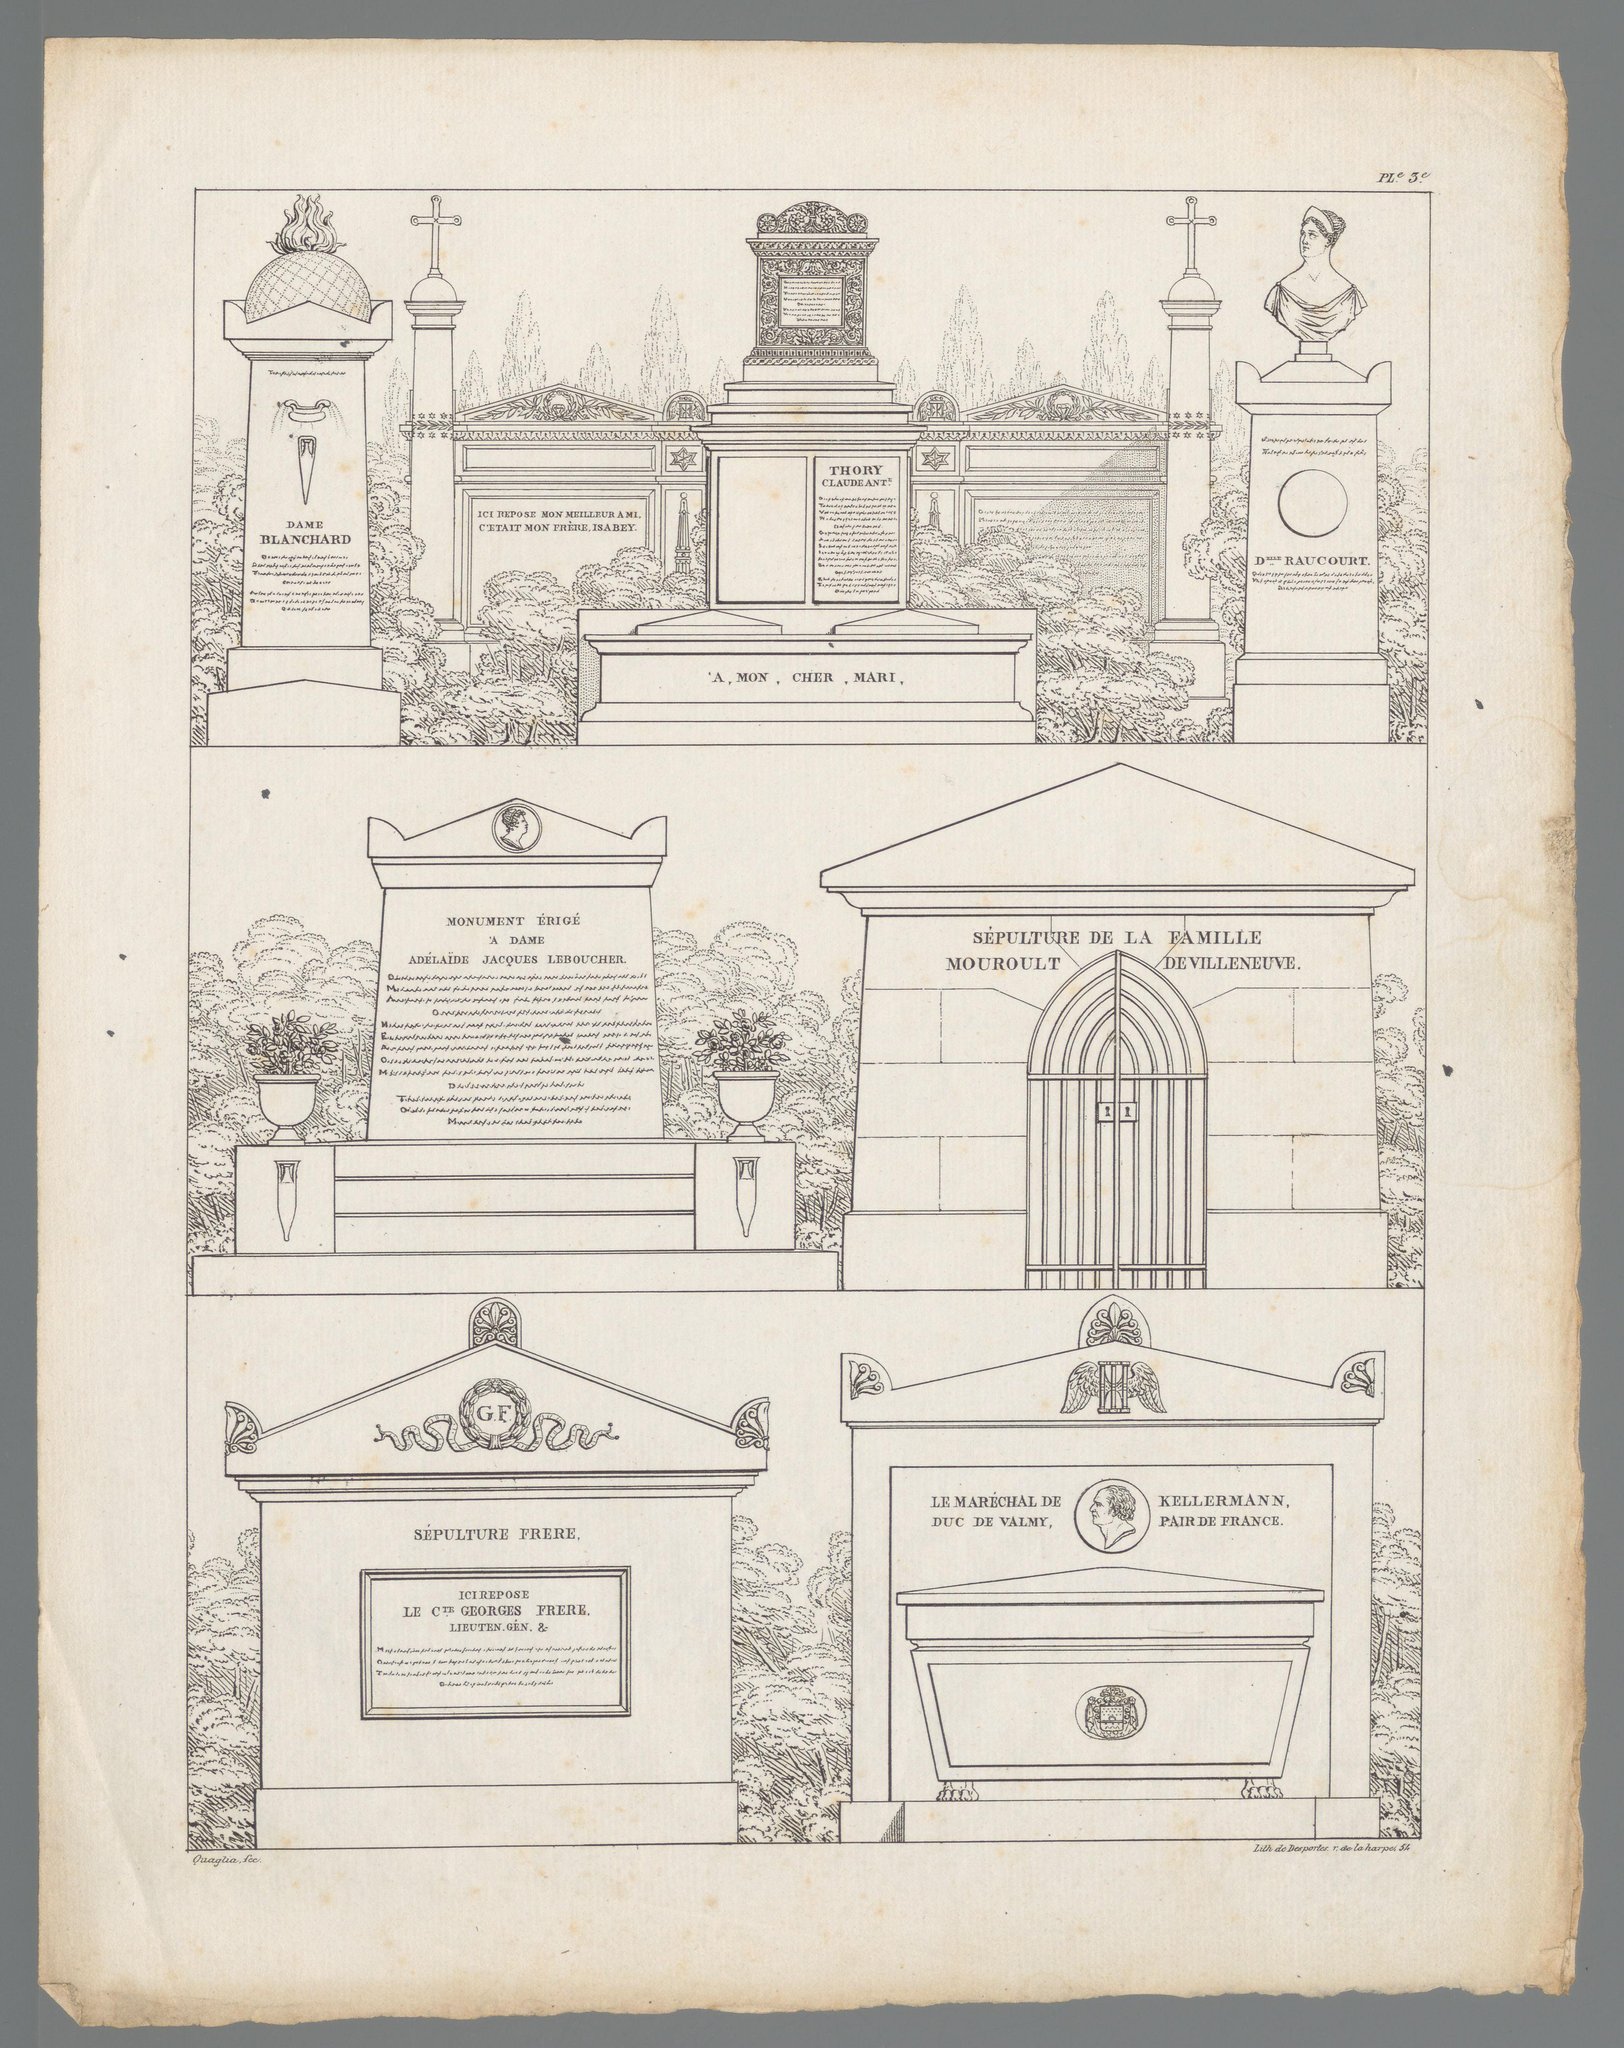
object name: print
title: Grafmonumenten op Père-Lachaise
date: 1803-1869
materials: paper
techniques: lithograph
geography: paris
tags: cemetery, park-like burying ground